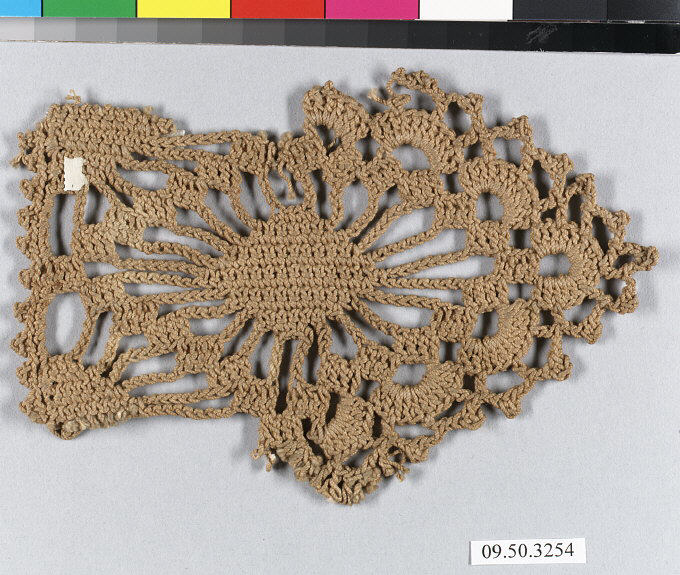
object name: sample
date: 1801-1900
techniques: crochet